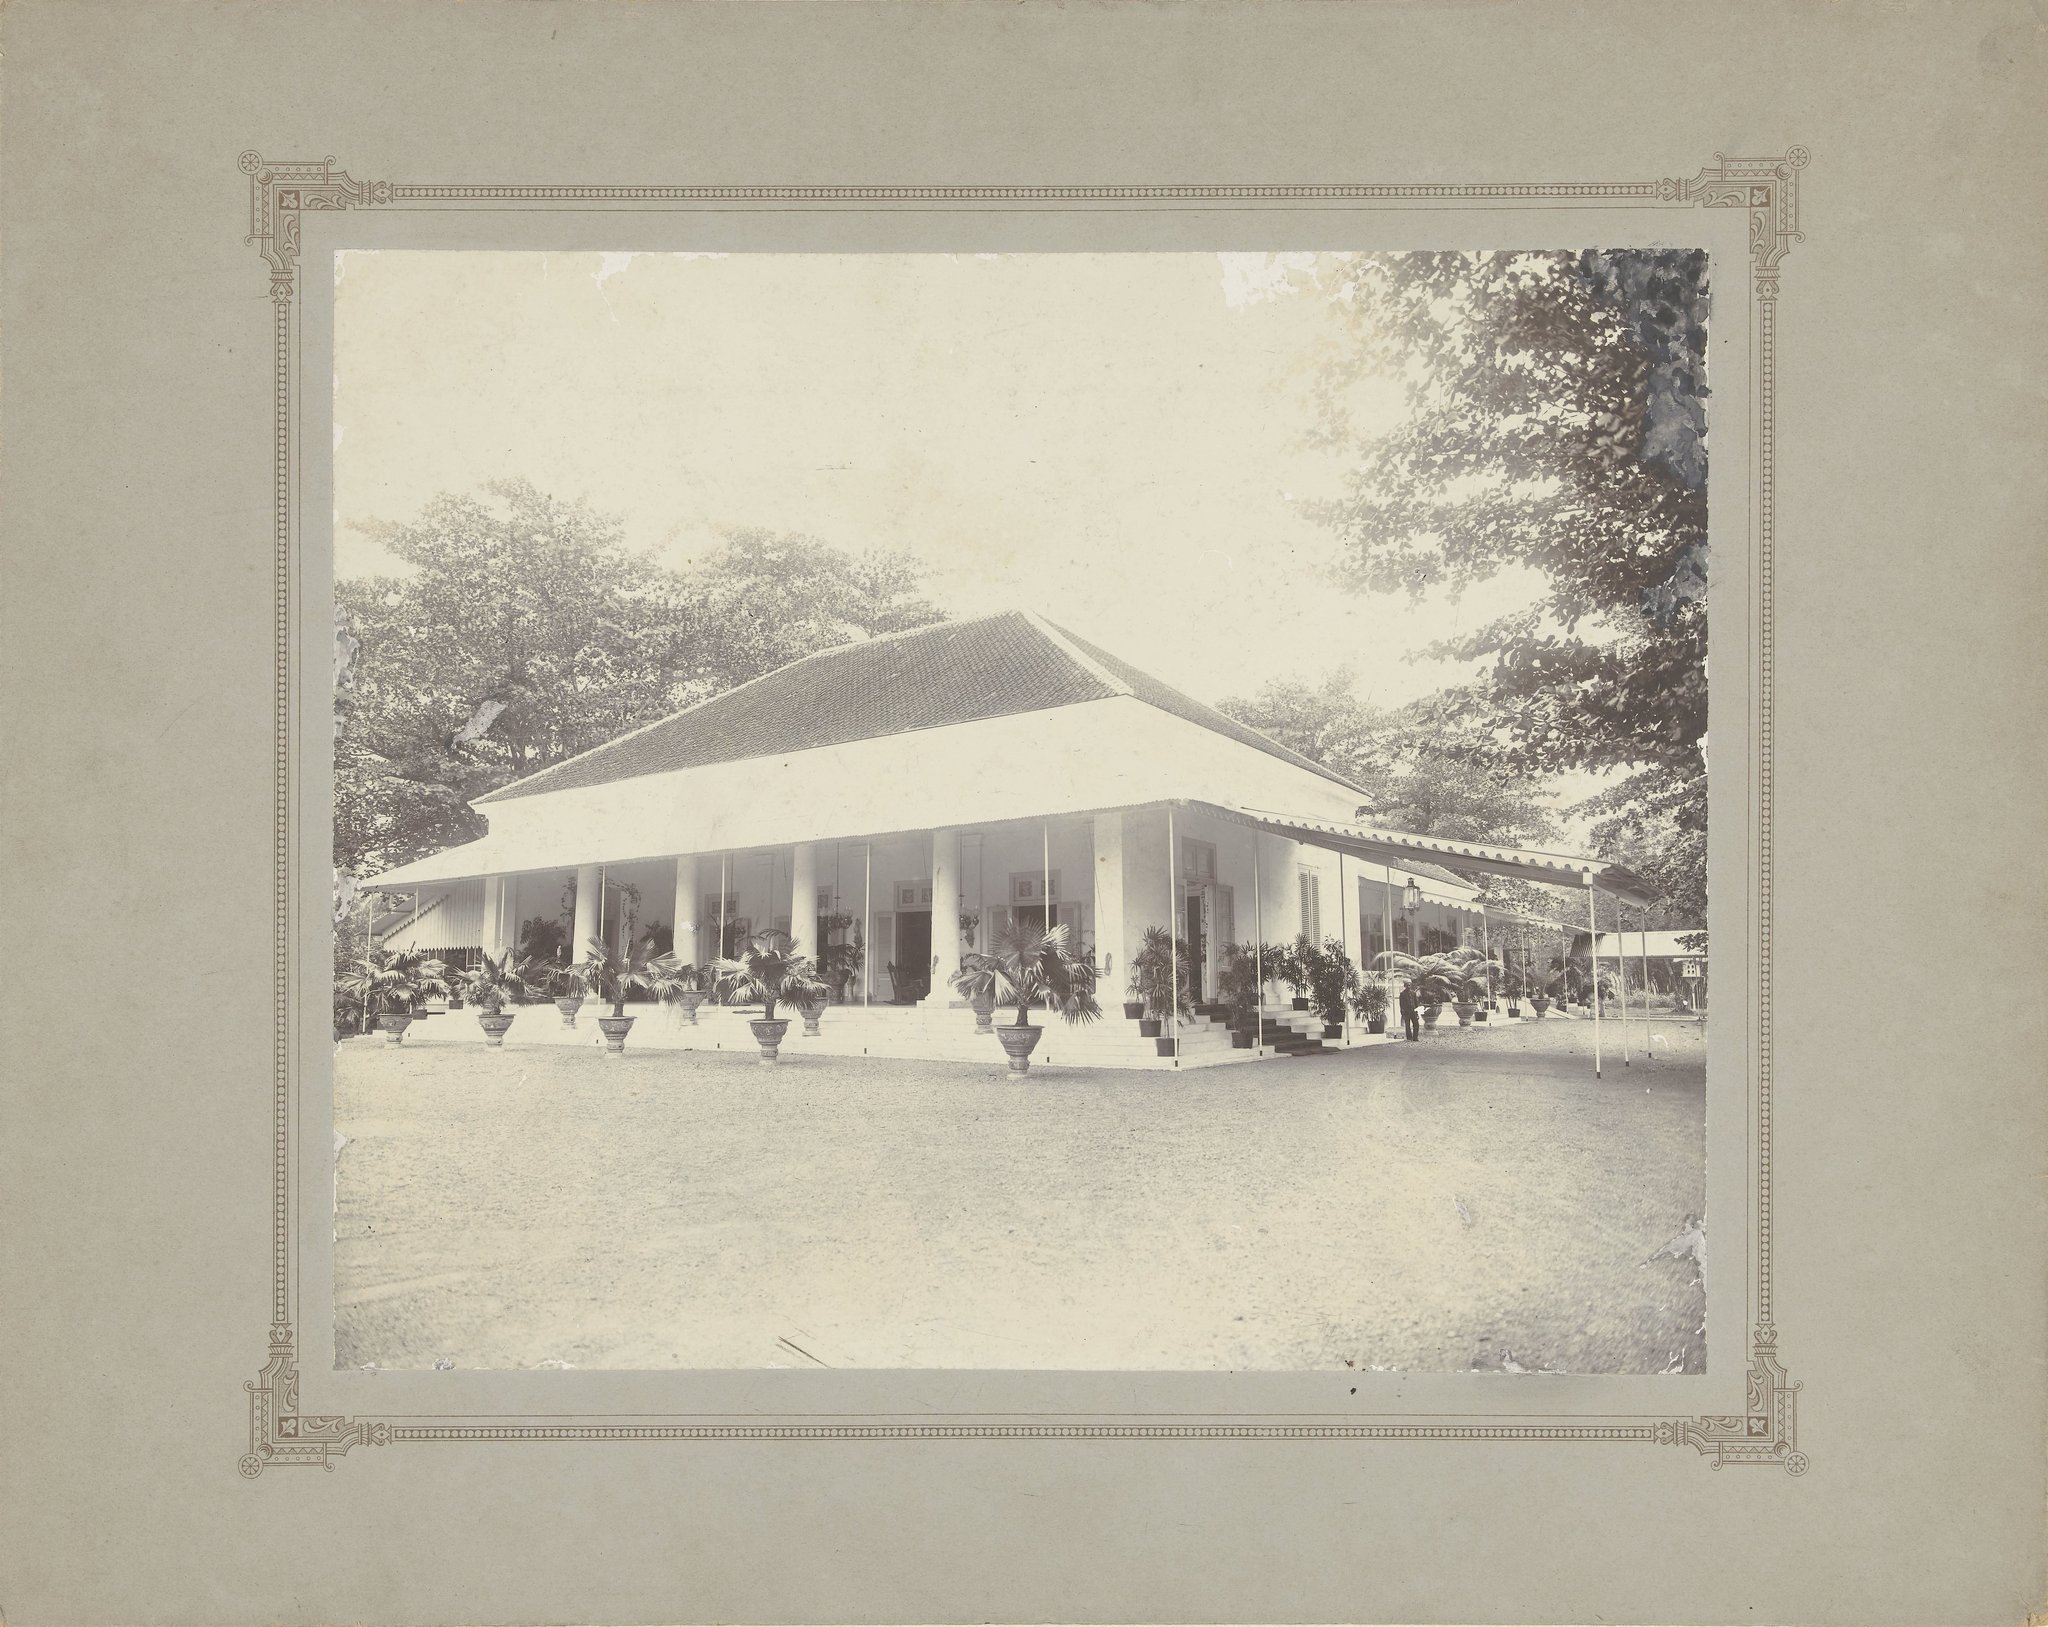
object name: photograph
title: Villa met veranda en palmen in Nederlands-Indië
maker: Anonymous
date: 1895-1920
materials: paper, cardboard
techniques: retouching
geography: dutch east indies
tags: loggia, verandah, porch, country-house, dutch east indies, the